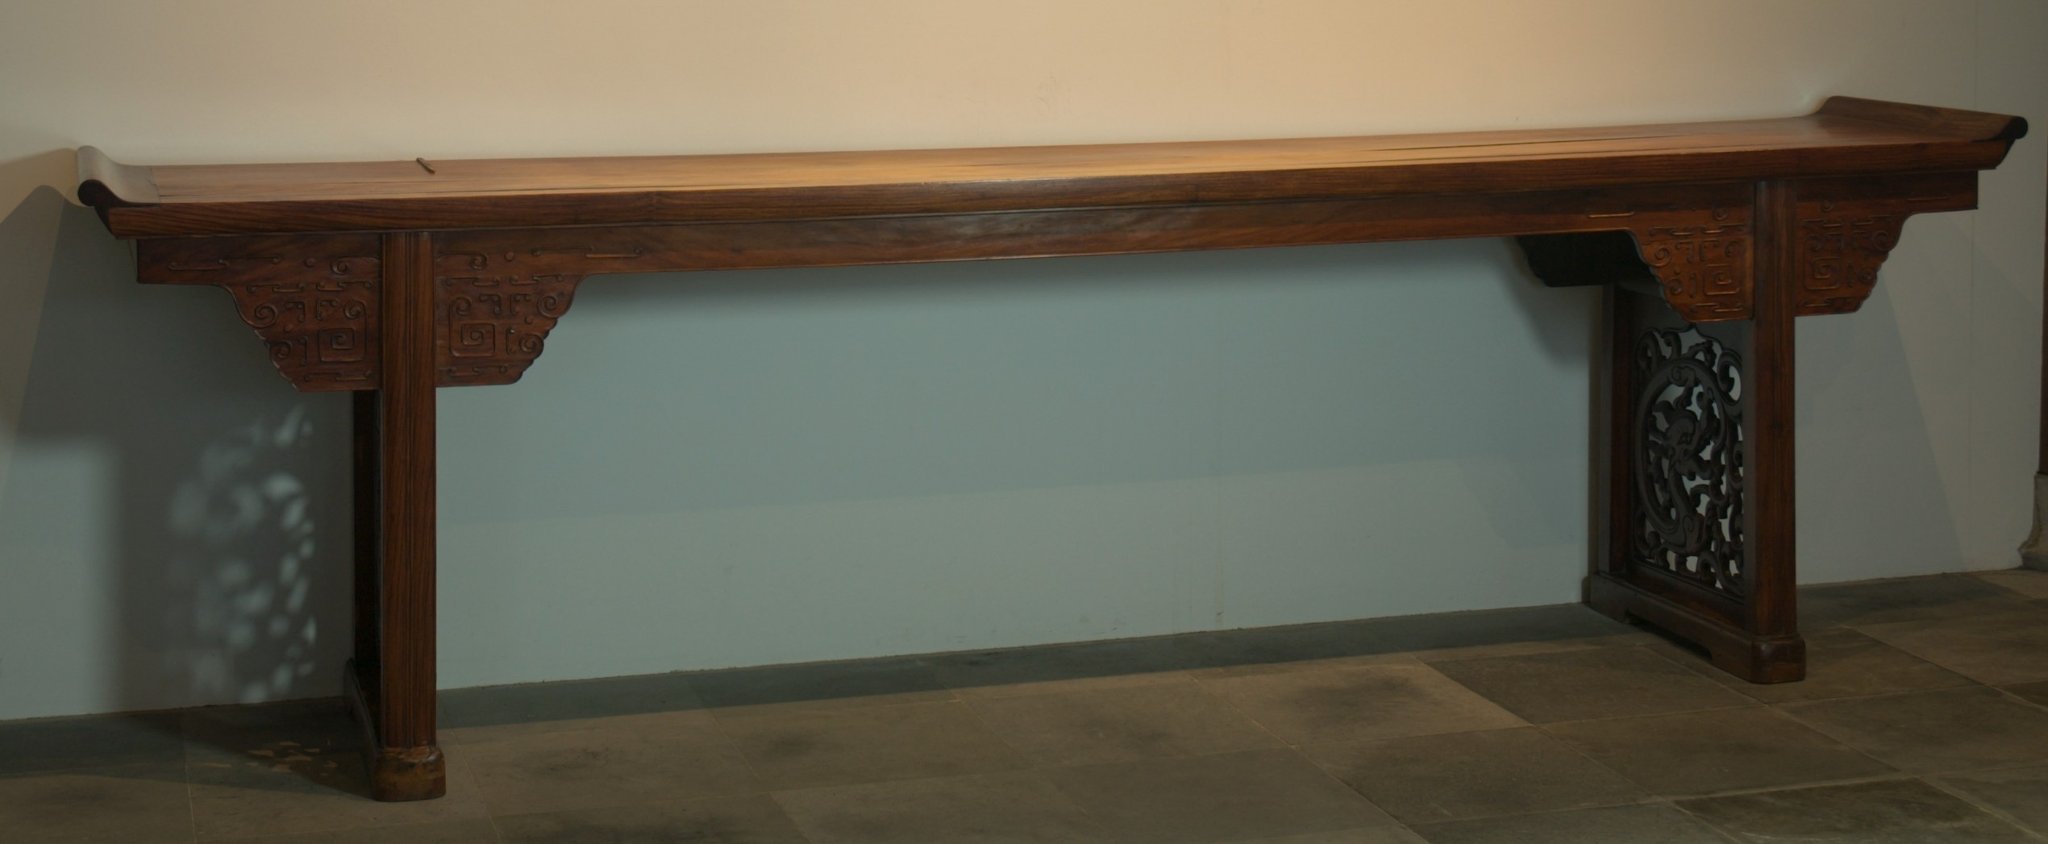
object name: table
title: Long Side Table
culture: chinese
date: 1601-1800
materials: wood